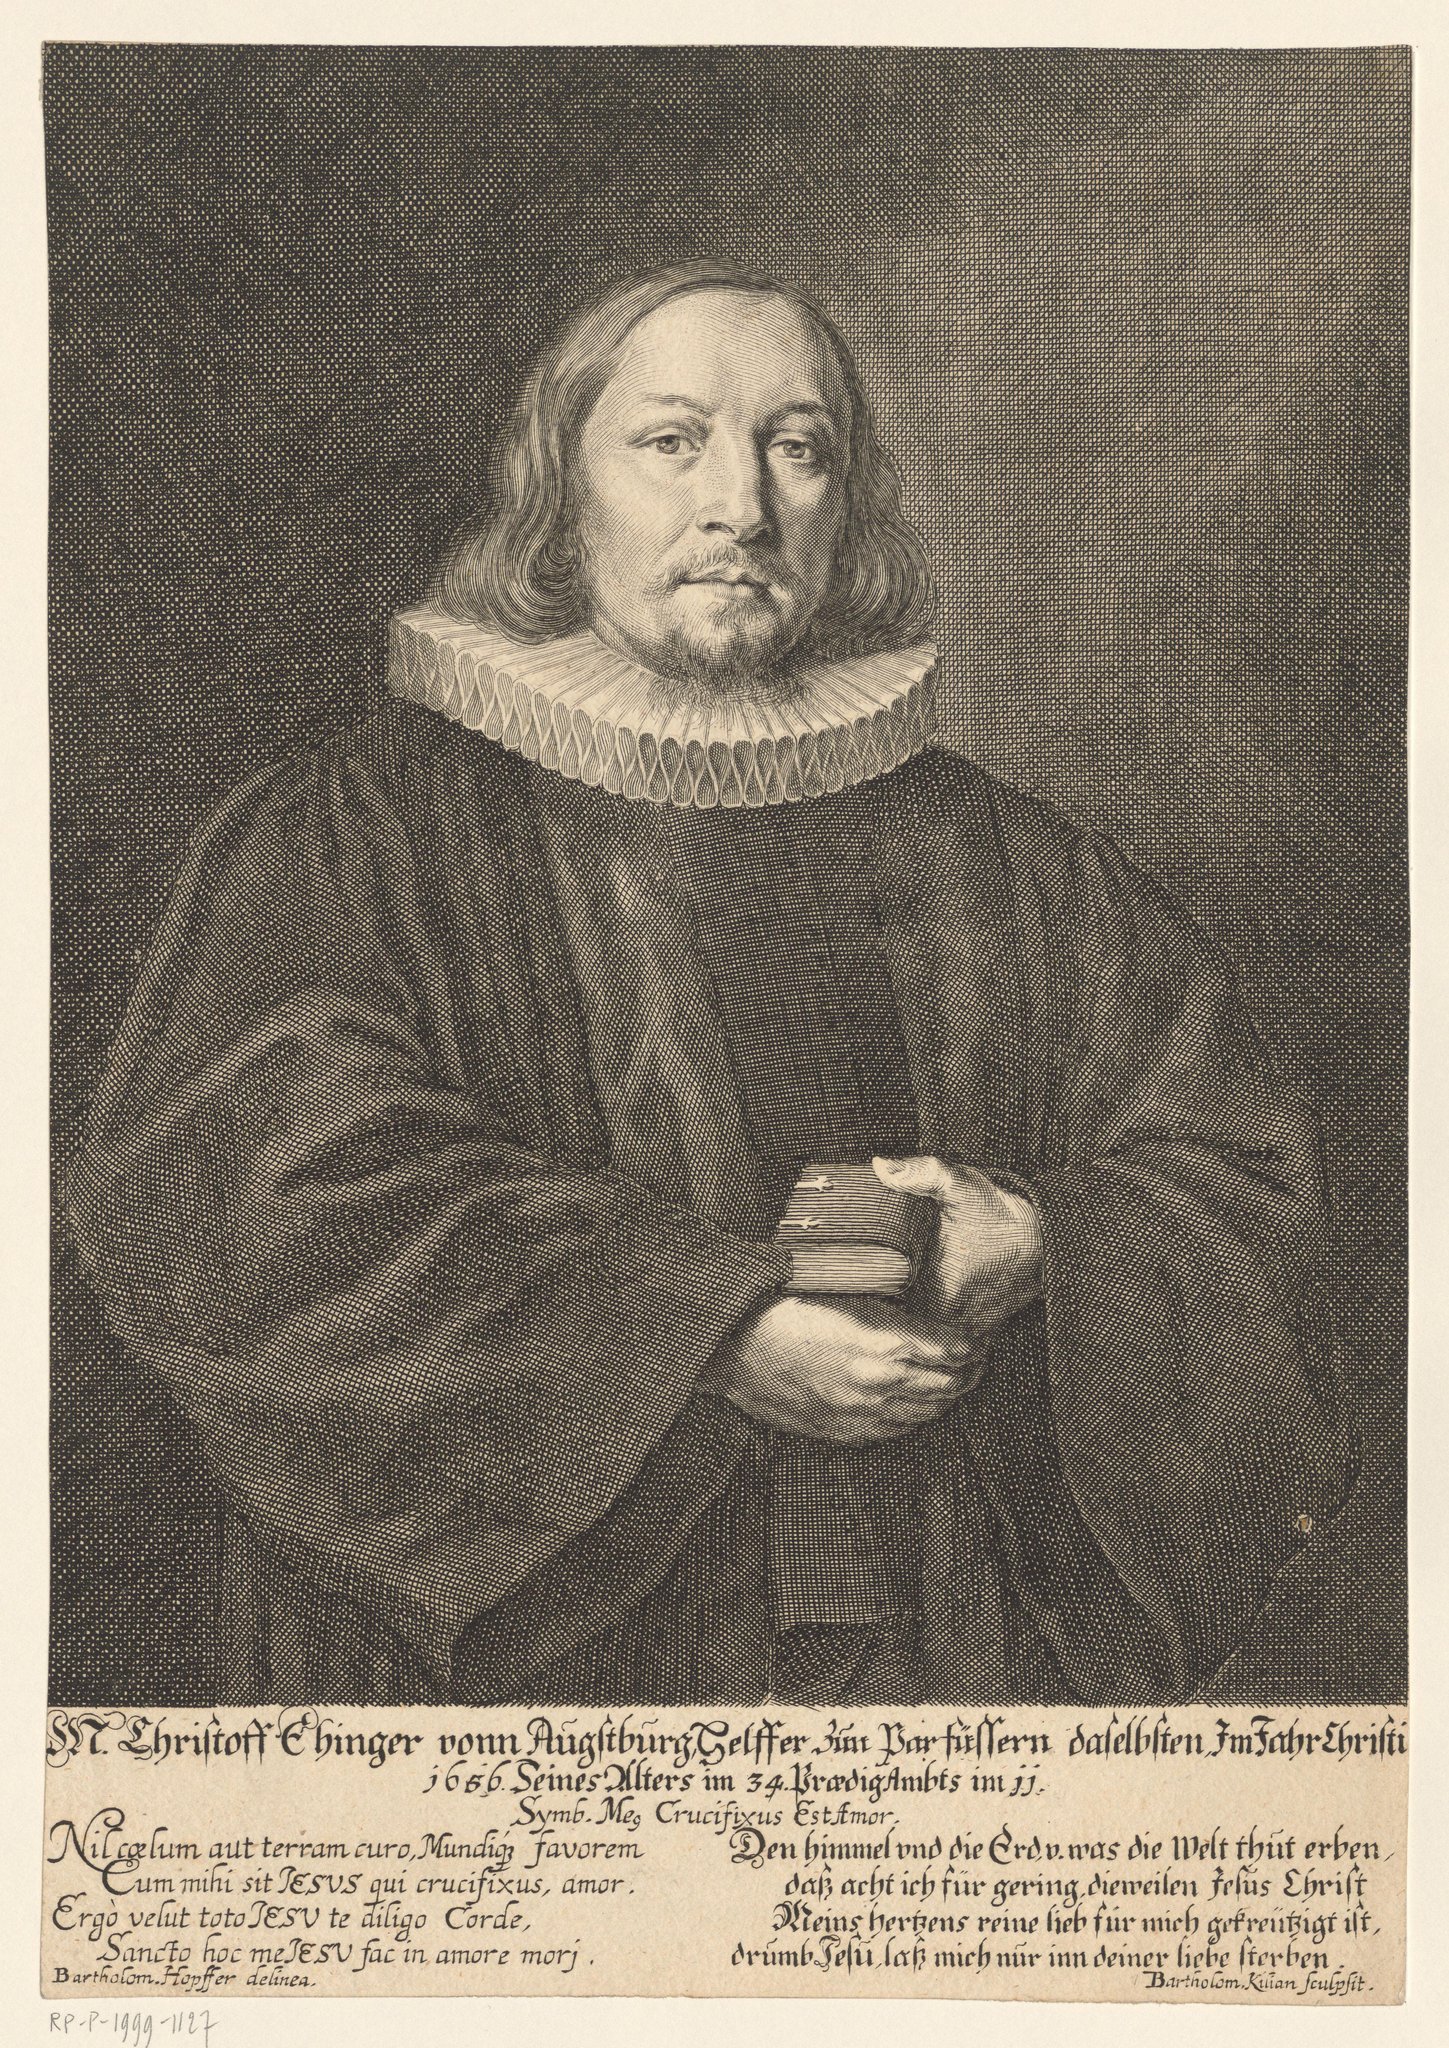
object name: print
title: Portret van Christoph Ehinger op 34-jarige leeftijd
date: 1656-1658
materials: paper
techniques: engraving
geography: germany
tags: augsburg, theologian, historical persons, book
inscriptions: collector's mark: Lugt 2228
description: Tekst in het Duits en Latijn onderaan in de marge.